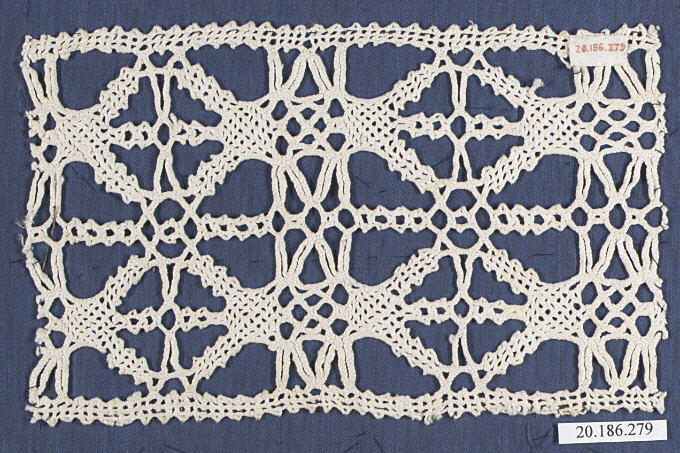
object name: insertion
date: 1501-1600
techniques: lace